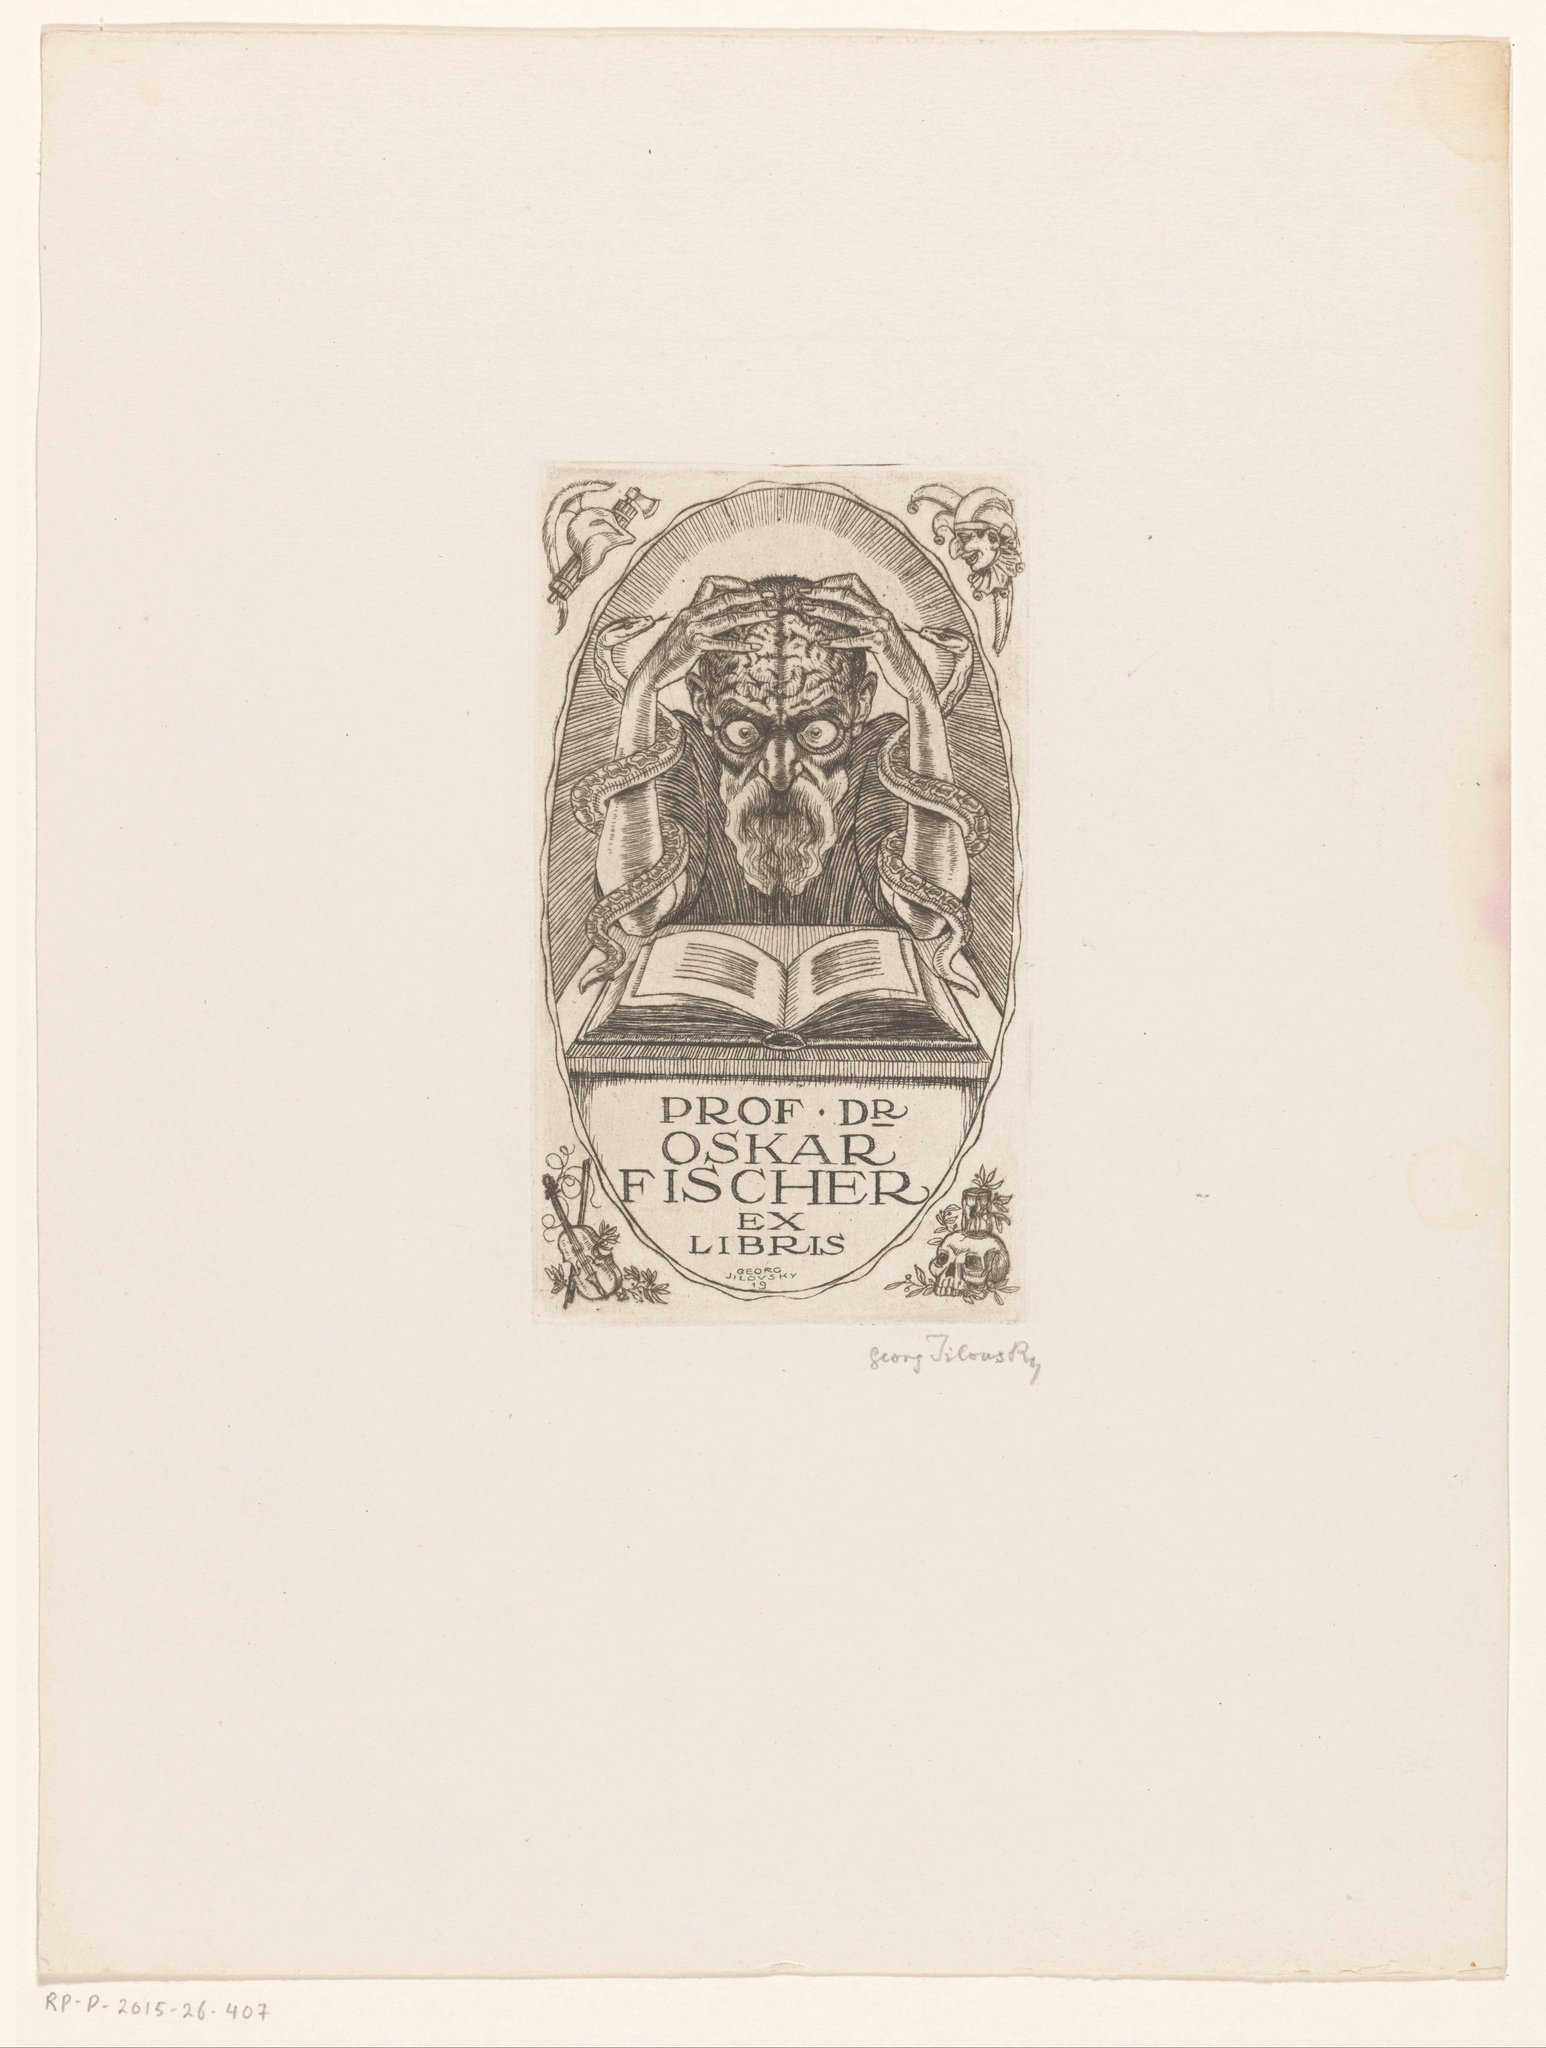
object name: bookplate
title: Ex libris van Prof. Dr. Oskar Fischer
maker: georg jilovsky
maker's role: painter, print maker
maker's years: 1884-1958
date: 1919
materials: paper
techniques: etching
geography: prague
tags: snakes, brains, ex-libris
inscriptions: collector's mark: Lugt 2228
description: Ovaal met een lezende man voor een opengeslagen boek, zijn hersenen zichtbaar en twee slangen kronkelend om zijn armen. In de hoeken een fascis met helm, een nar, een viool en een doodshoofd met zandloper.